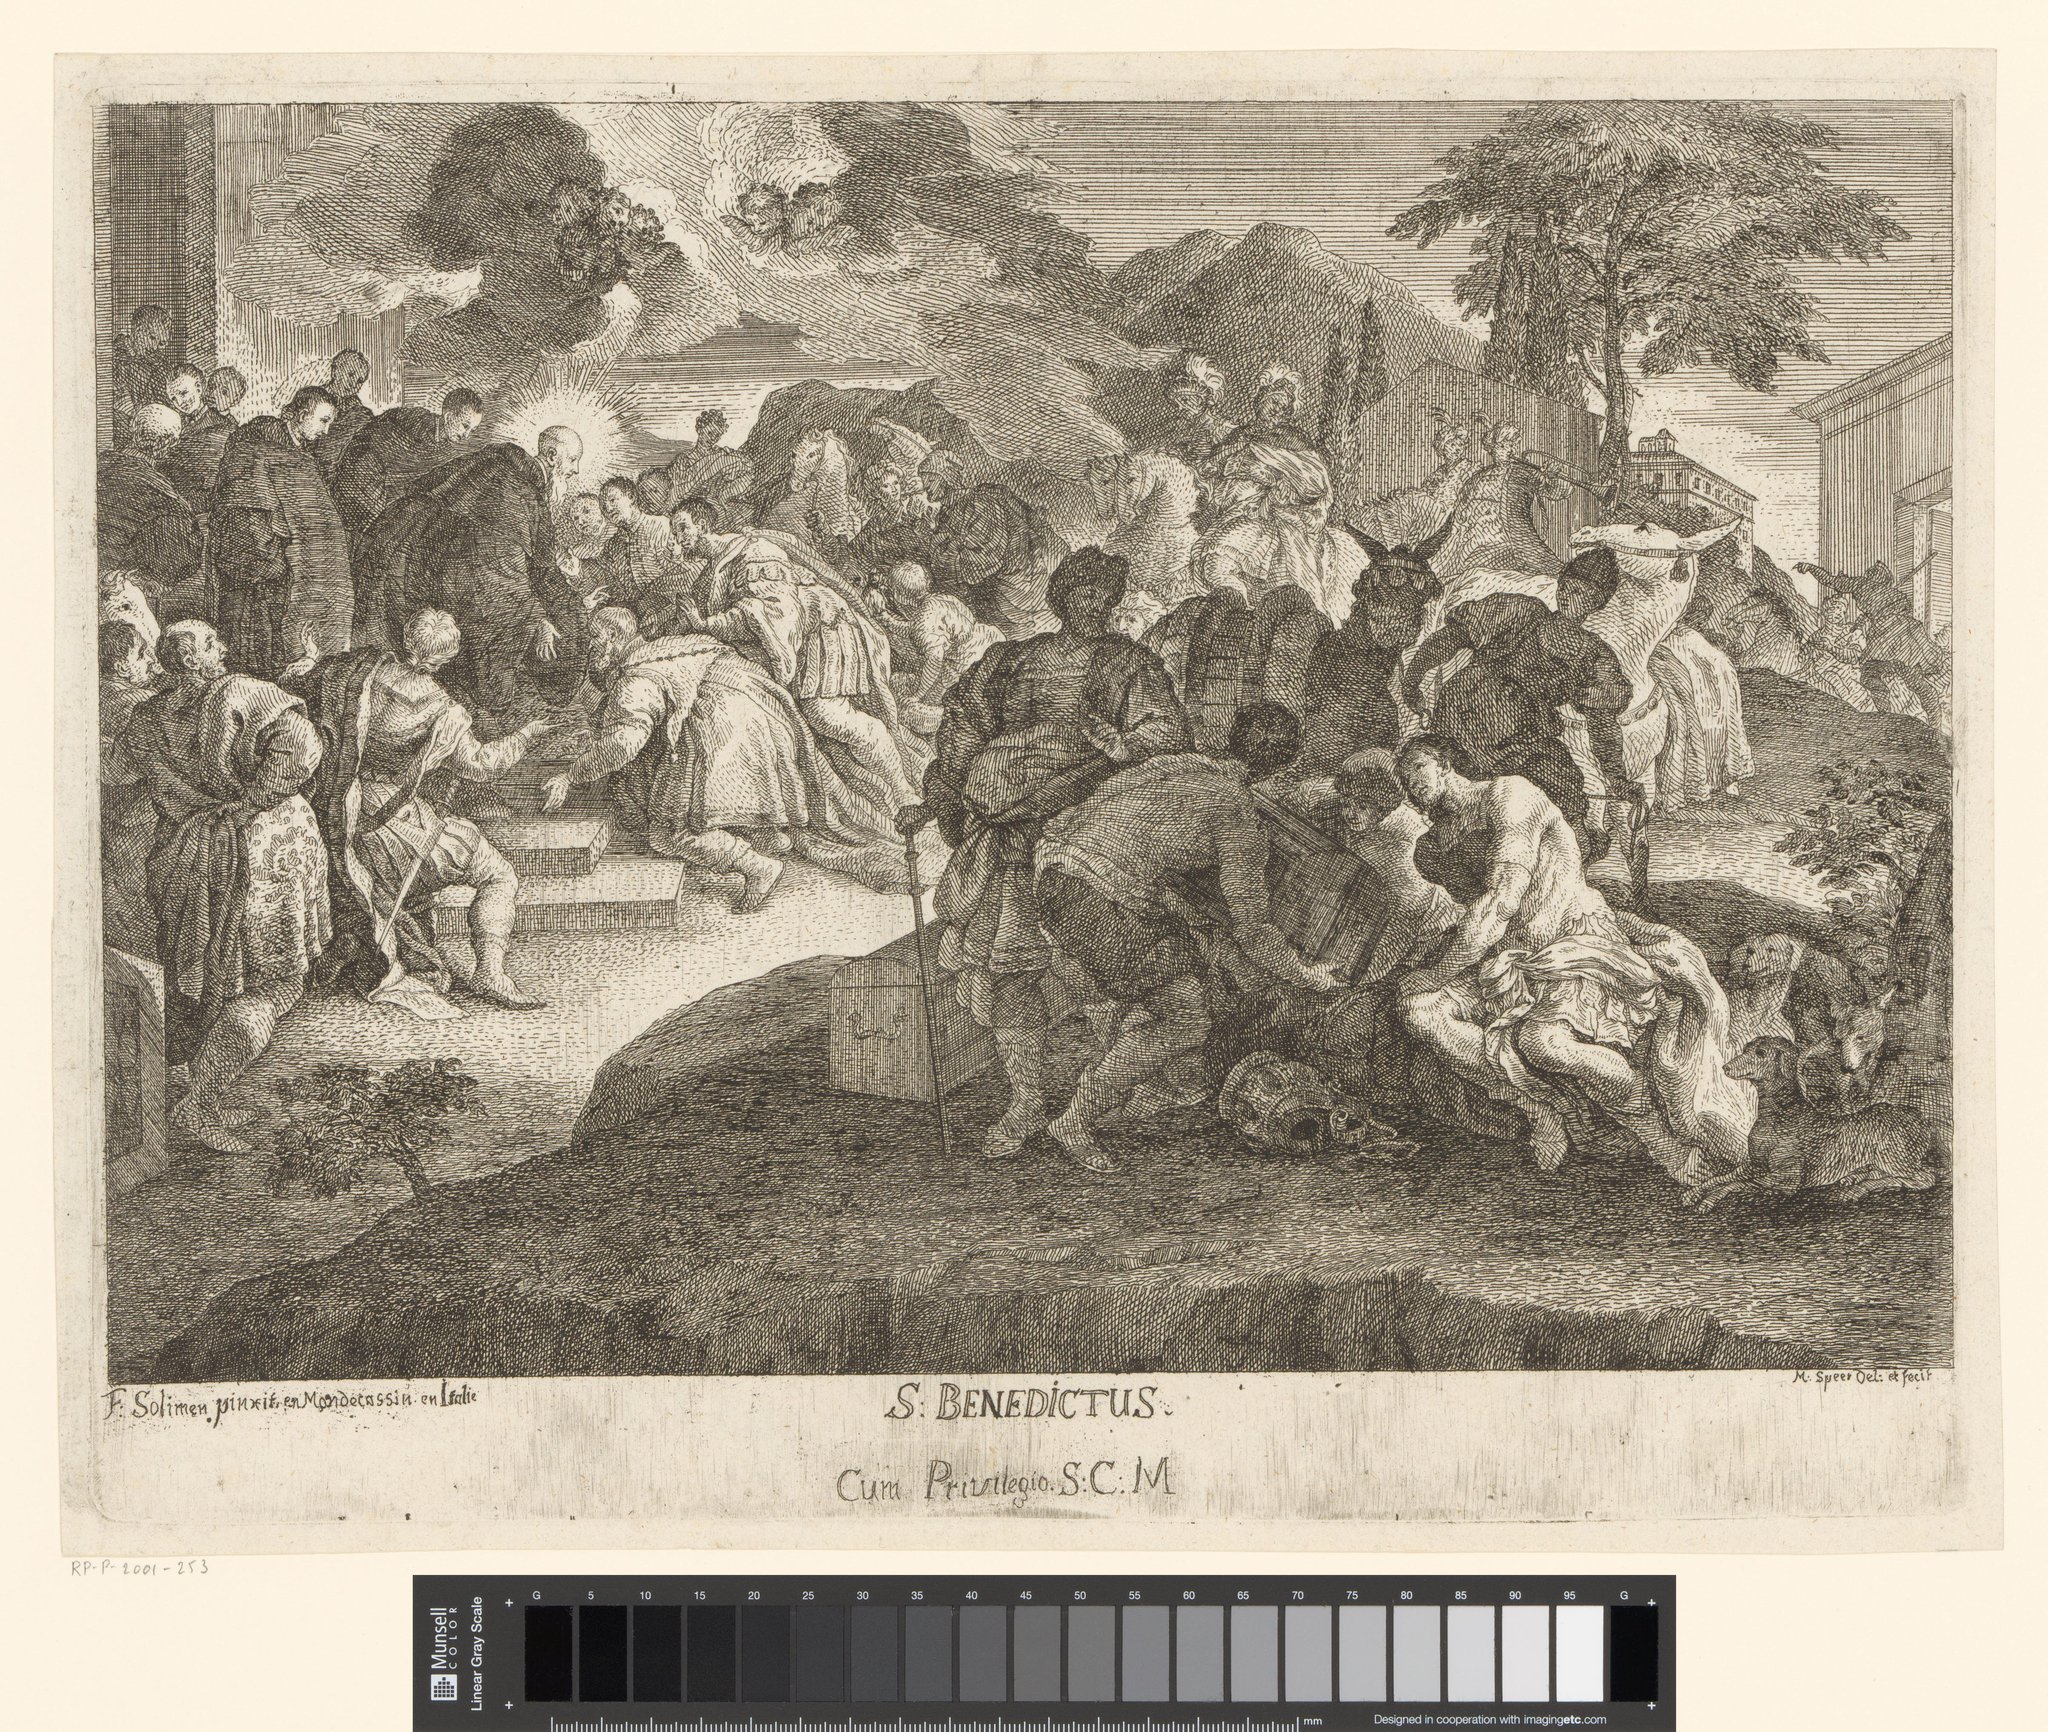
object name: print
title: S. Benedictus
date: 1725-1765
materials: paper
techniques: etching, intaglio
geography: regensburg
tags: benedict of nurcia, abbot of monte cassino and founder of the benedictine order; possible attributes: aspergillum, book, cup (sometimes broken), raven with loaf, sieve (or tray), money-chest, treasure-chest, money-box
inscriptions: collector's mark: Lugt 2228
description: Prent naar een vernietigde schildering in de Abdij van Monte Cassino.